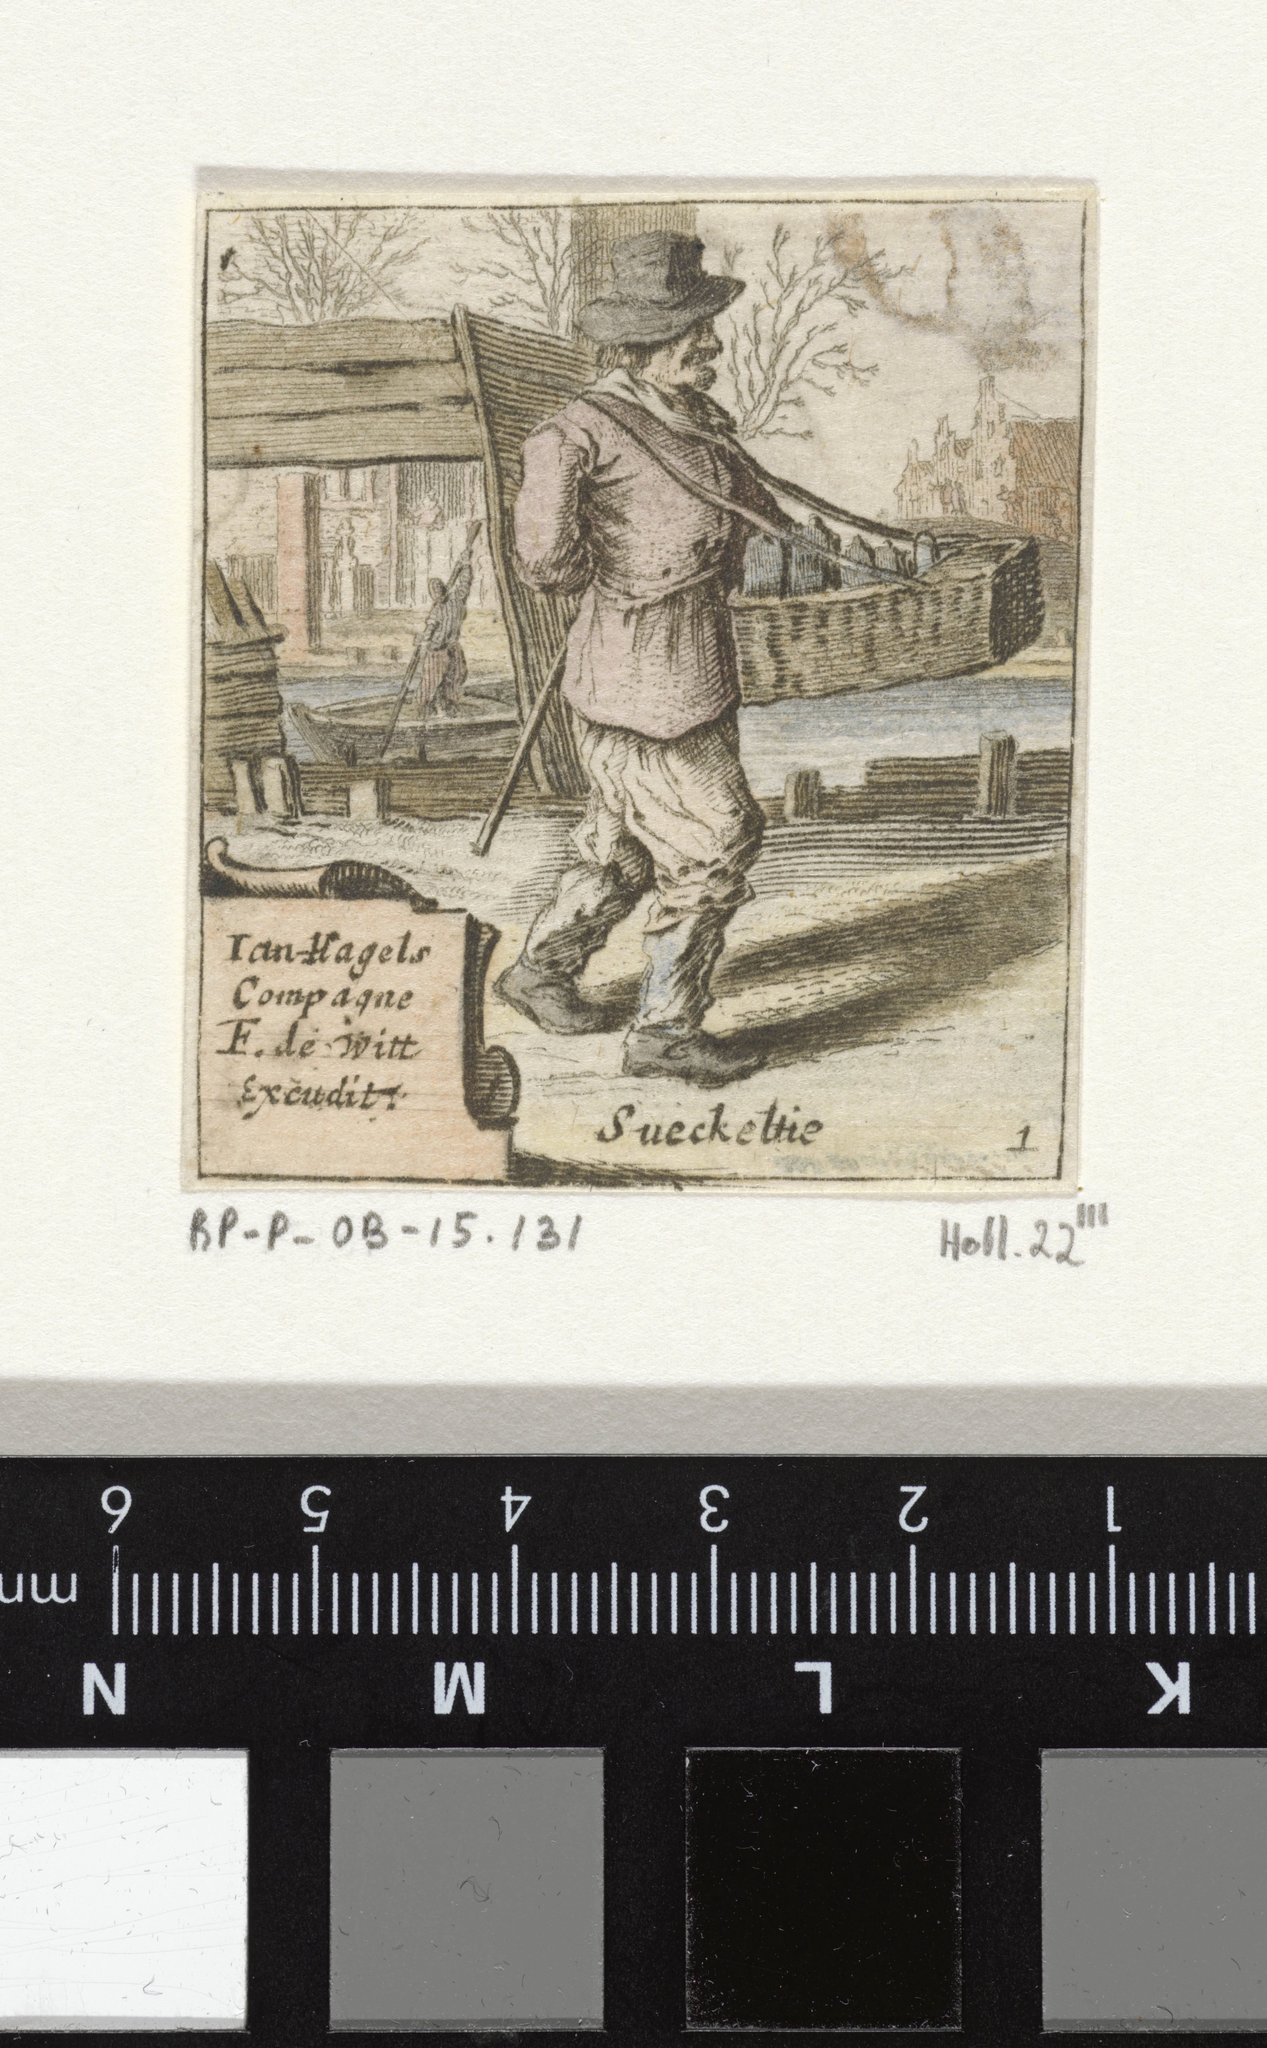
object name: print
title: Sueckeltie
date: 1638-1706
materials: paper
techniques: brush, engraving, etching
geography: amsterdam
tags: pedlar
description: Een marskramer (Sueckeltie) loopt met een mand met koopwaren langs een dorp. Op de achtergrond een kanaal, een man in een boot en enkele huizen. De prent maakt deel uit van een serie van 32 prenten met genretaferelen.